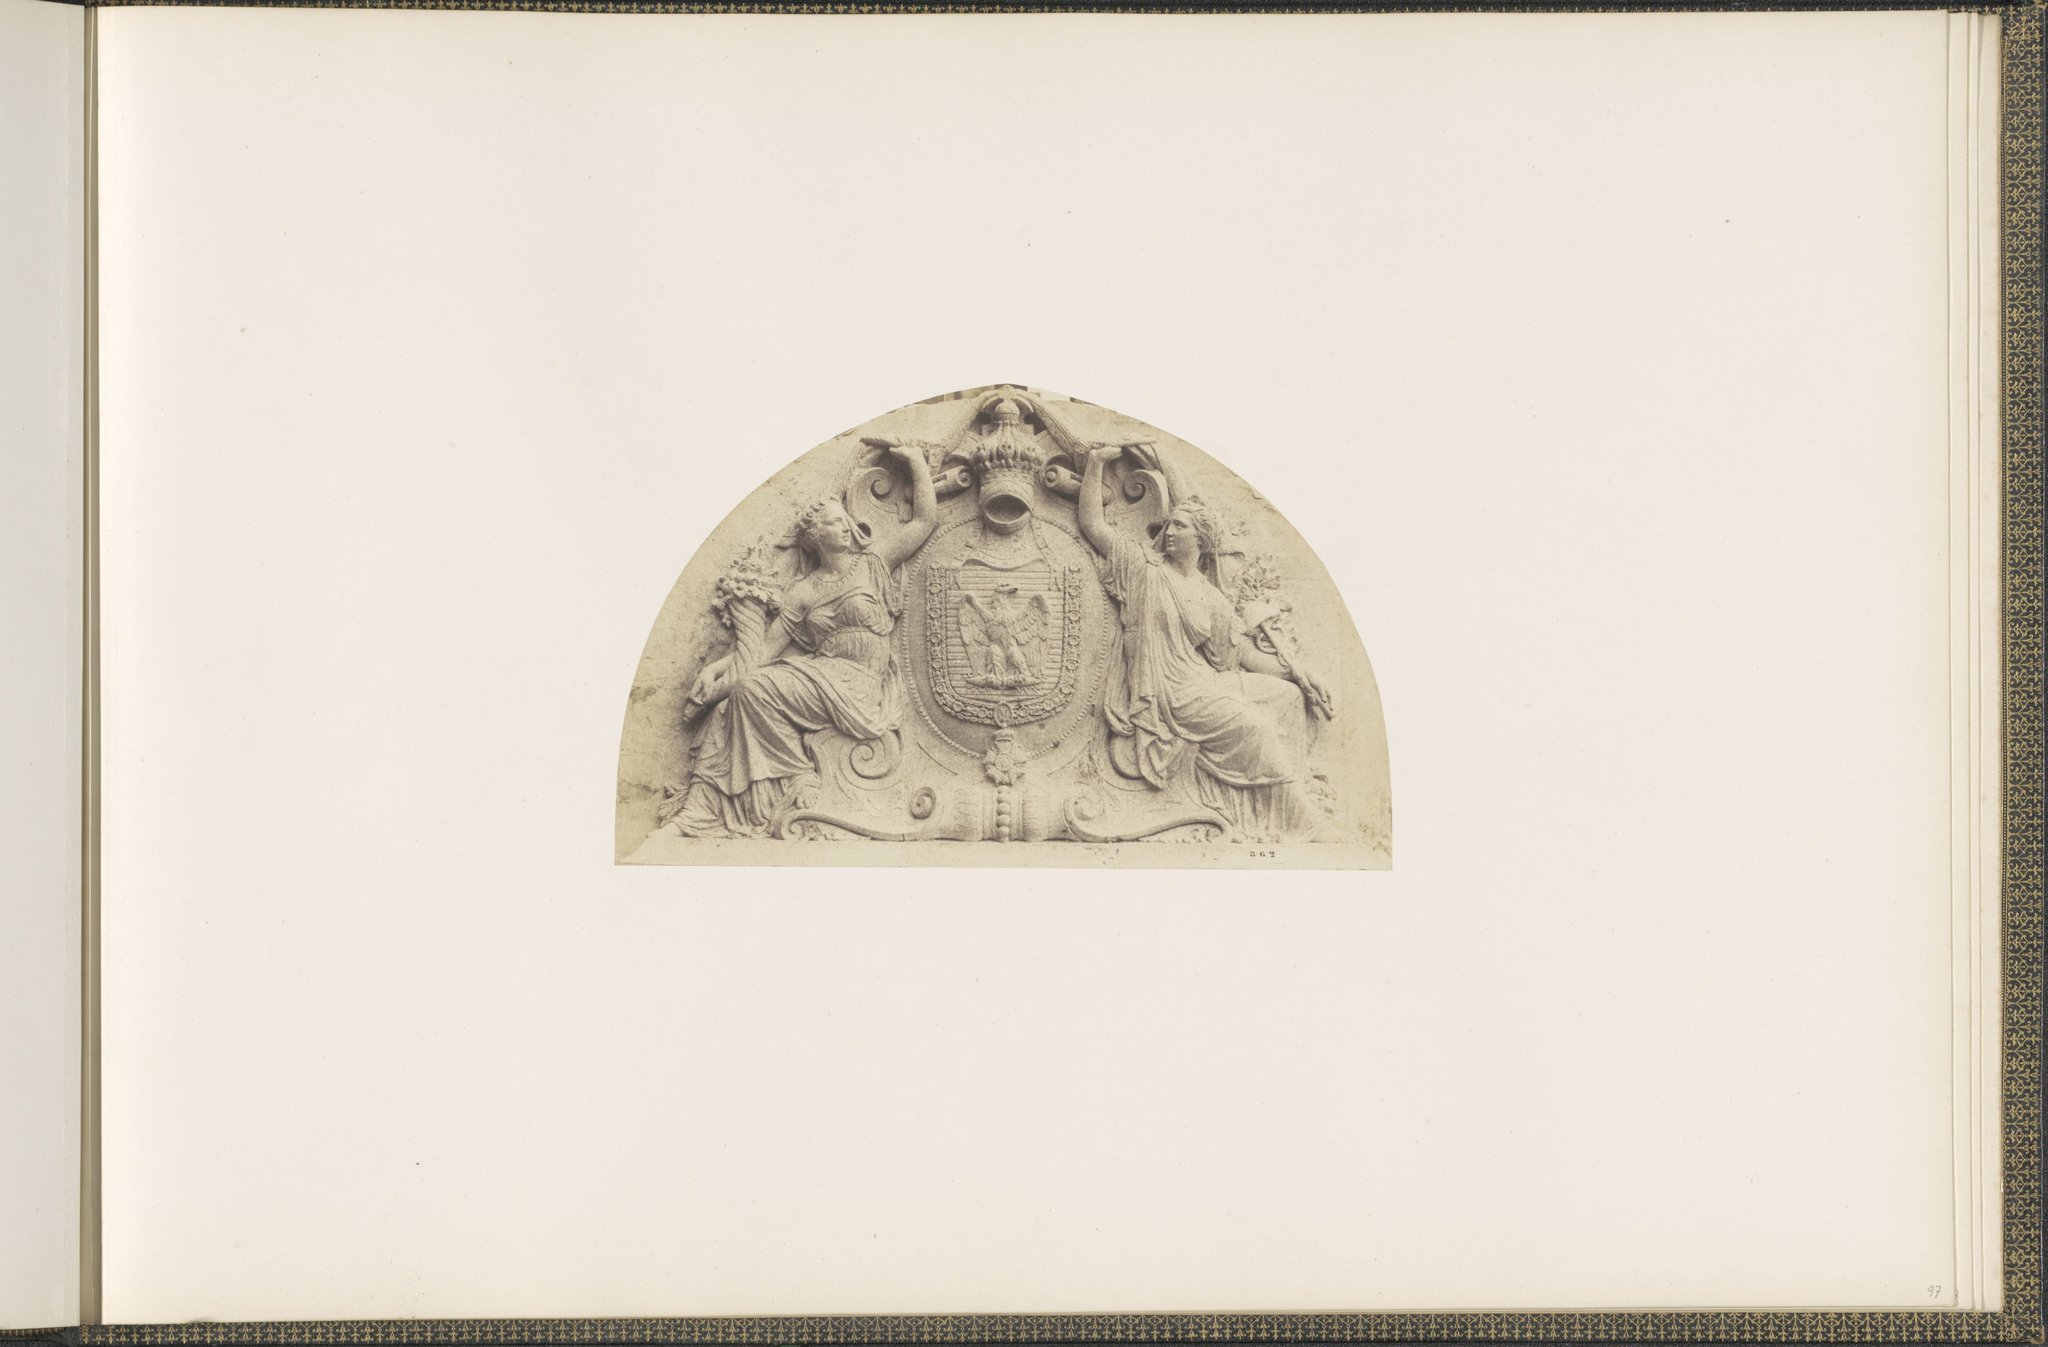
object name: album leaf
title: Gipsmodel voor beeldhouwwerk op het Palais du Louvre: "L'Abondance et la Paix" door Théodore Gruyère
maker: édouard denis baldus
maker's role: fotograaf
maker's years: 1813-1889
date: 1855-1857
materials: paper, photographic support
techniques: salted paper print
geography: paris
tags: piece of sculpture, reproduction of a piece of sculpture, permanent exhibition, museum, paris, tuileries palace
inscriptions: number: ‘862’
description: Onderdeel van Réunion des Tuileries au Louvre 1852-1857, album 4.